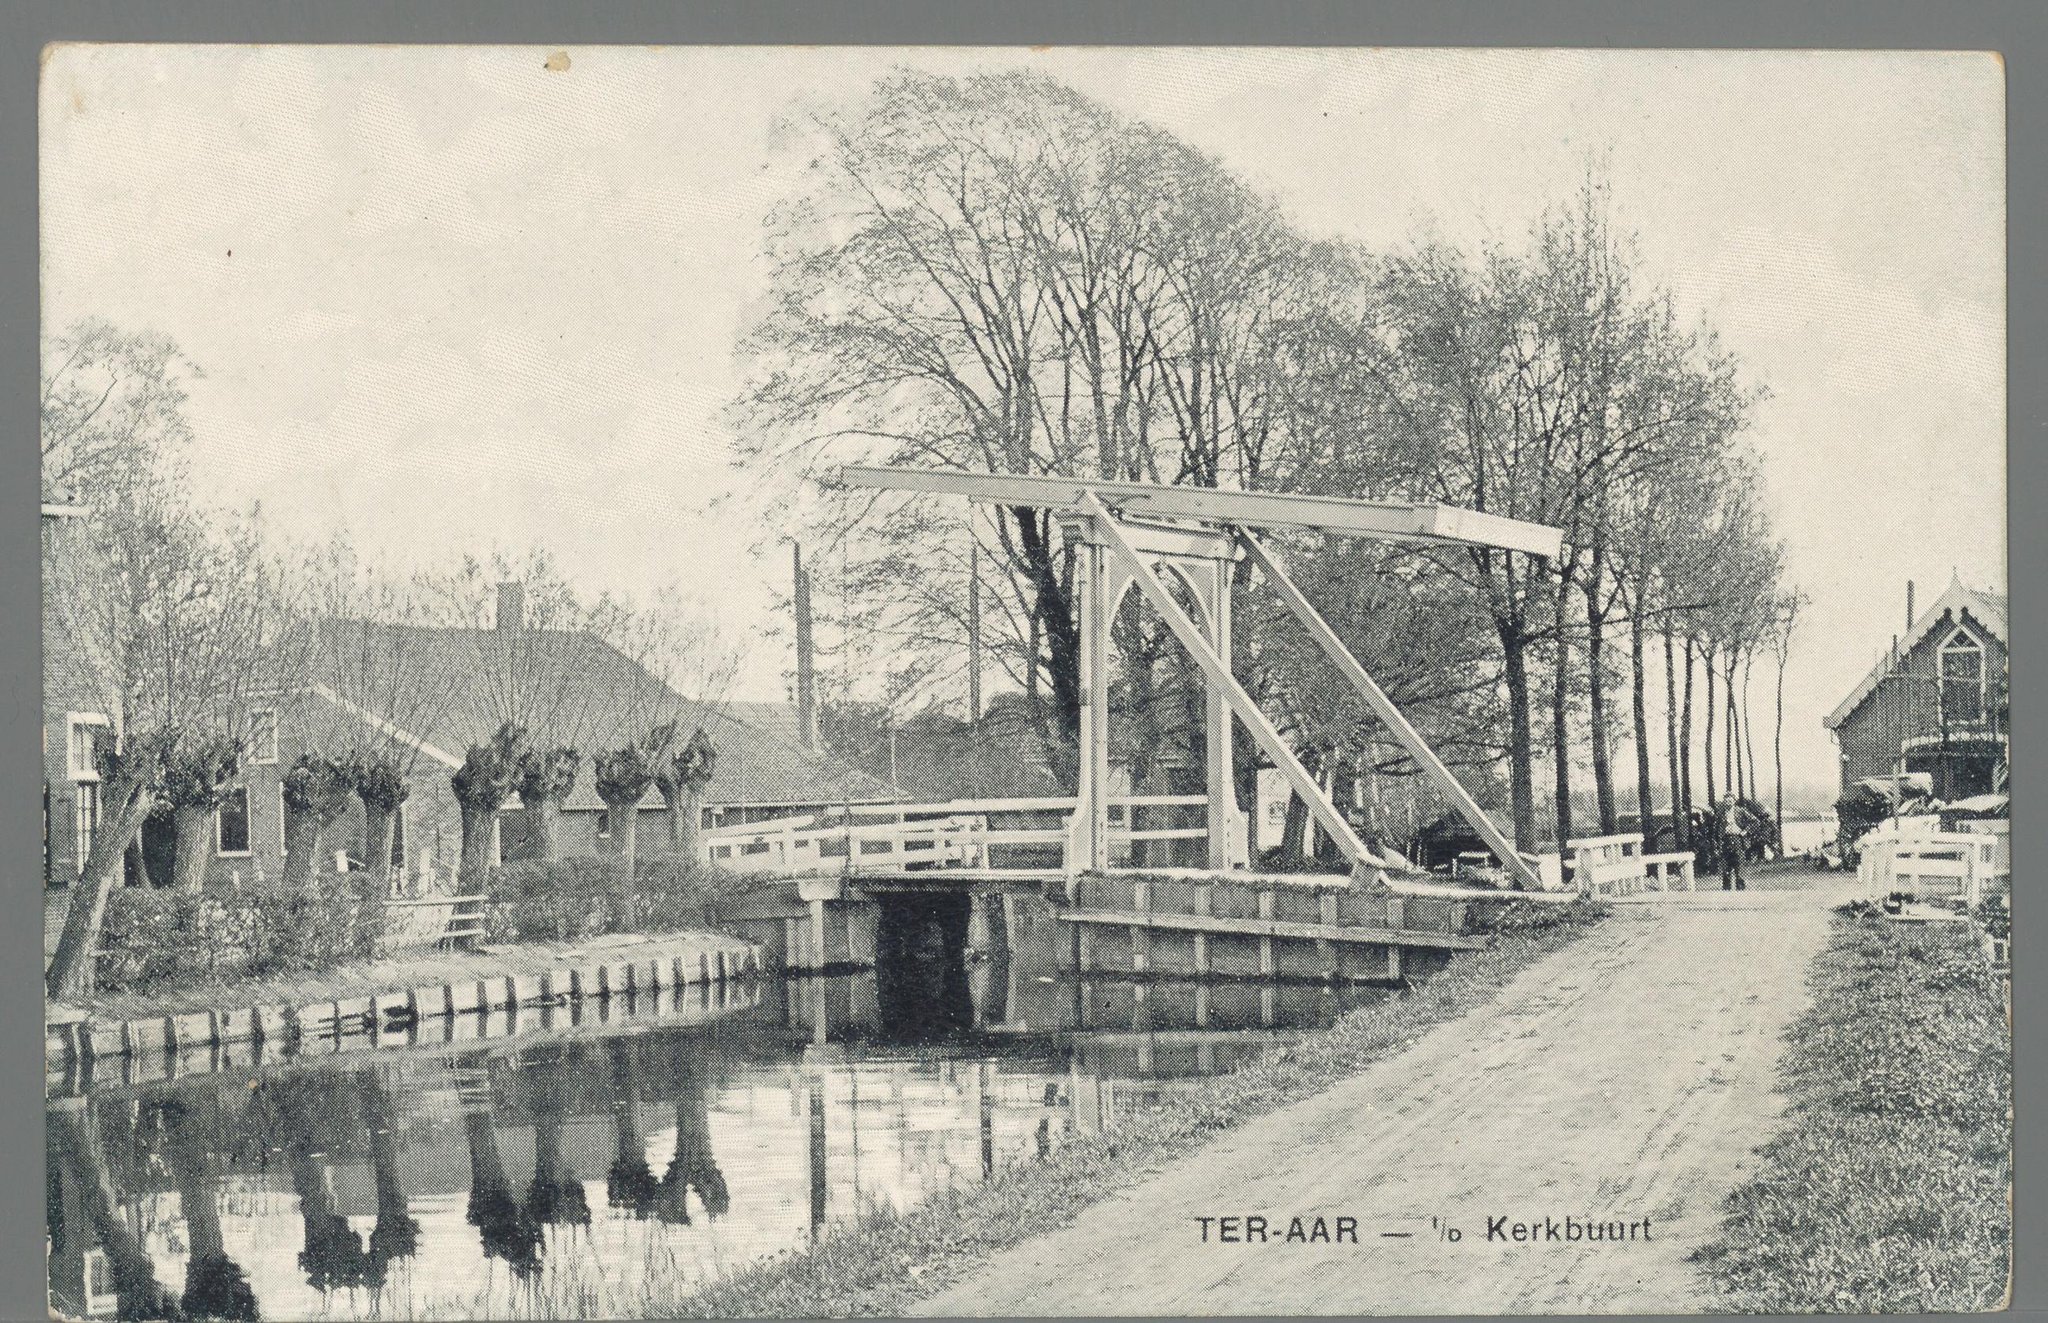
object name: photomechanical print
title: Ter-Aar - i/d Kerkbuurt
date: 1905-1930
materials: cardboard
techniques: autotype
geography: amsterdam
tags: city-view, and landscape with man-made constructions, canals, waters (in village), bridge in village across river, canal, etc.